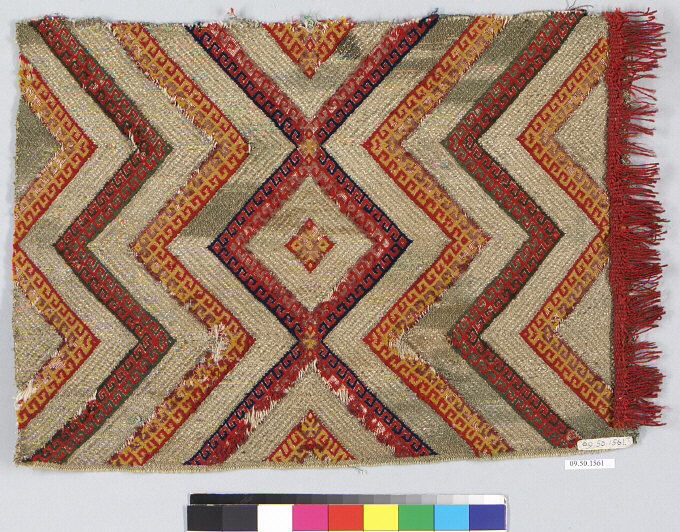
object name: fragment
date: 1801-1833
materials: canvas, metal thread, wool